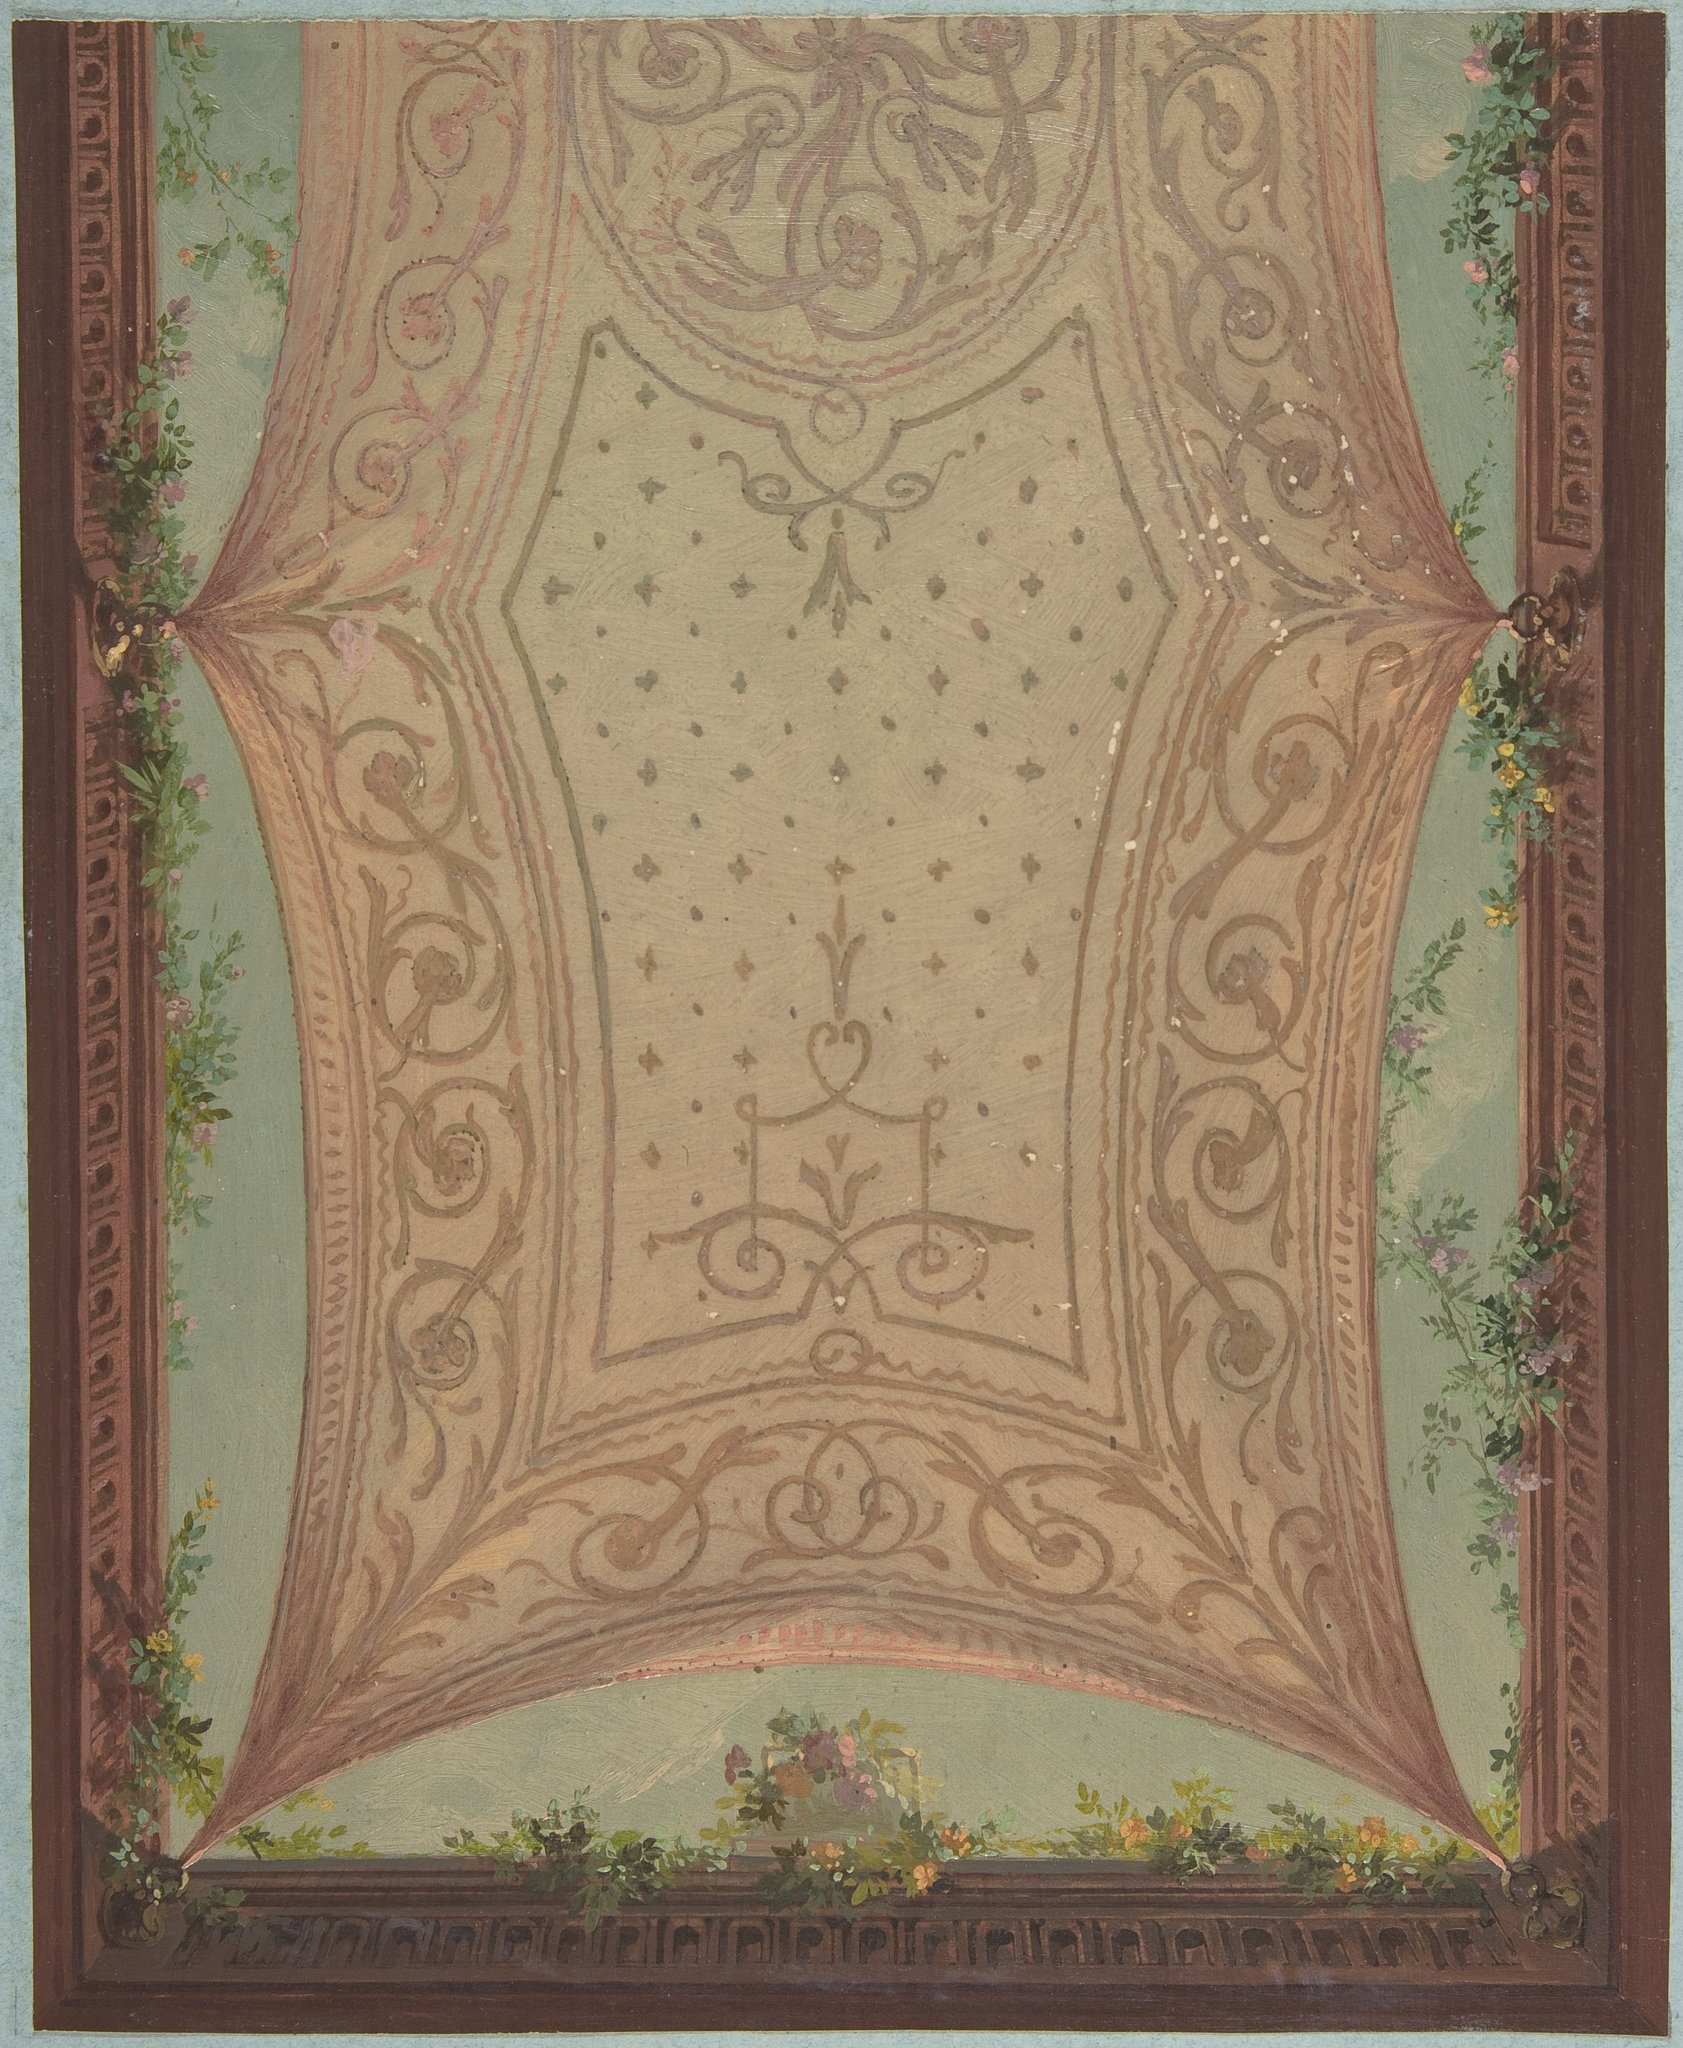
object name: drawing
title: Design for Gallery Ceiling, Hôtel Cottier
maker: jules-edmond-charles lachaise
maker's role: artist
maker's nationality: french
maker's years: 1897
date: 1879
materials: oil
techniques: brush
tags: ceilings